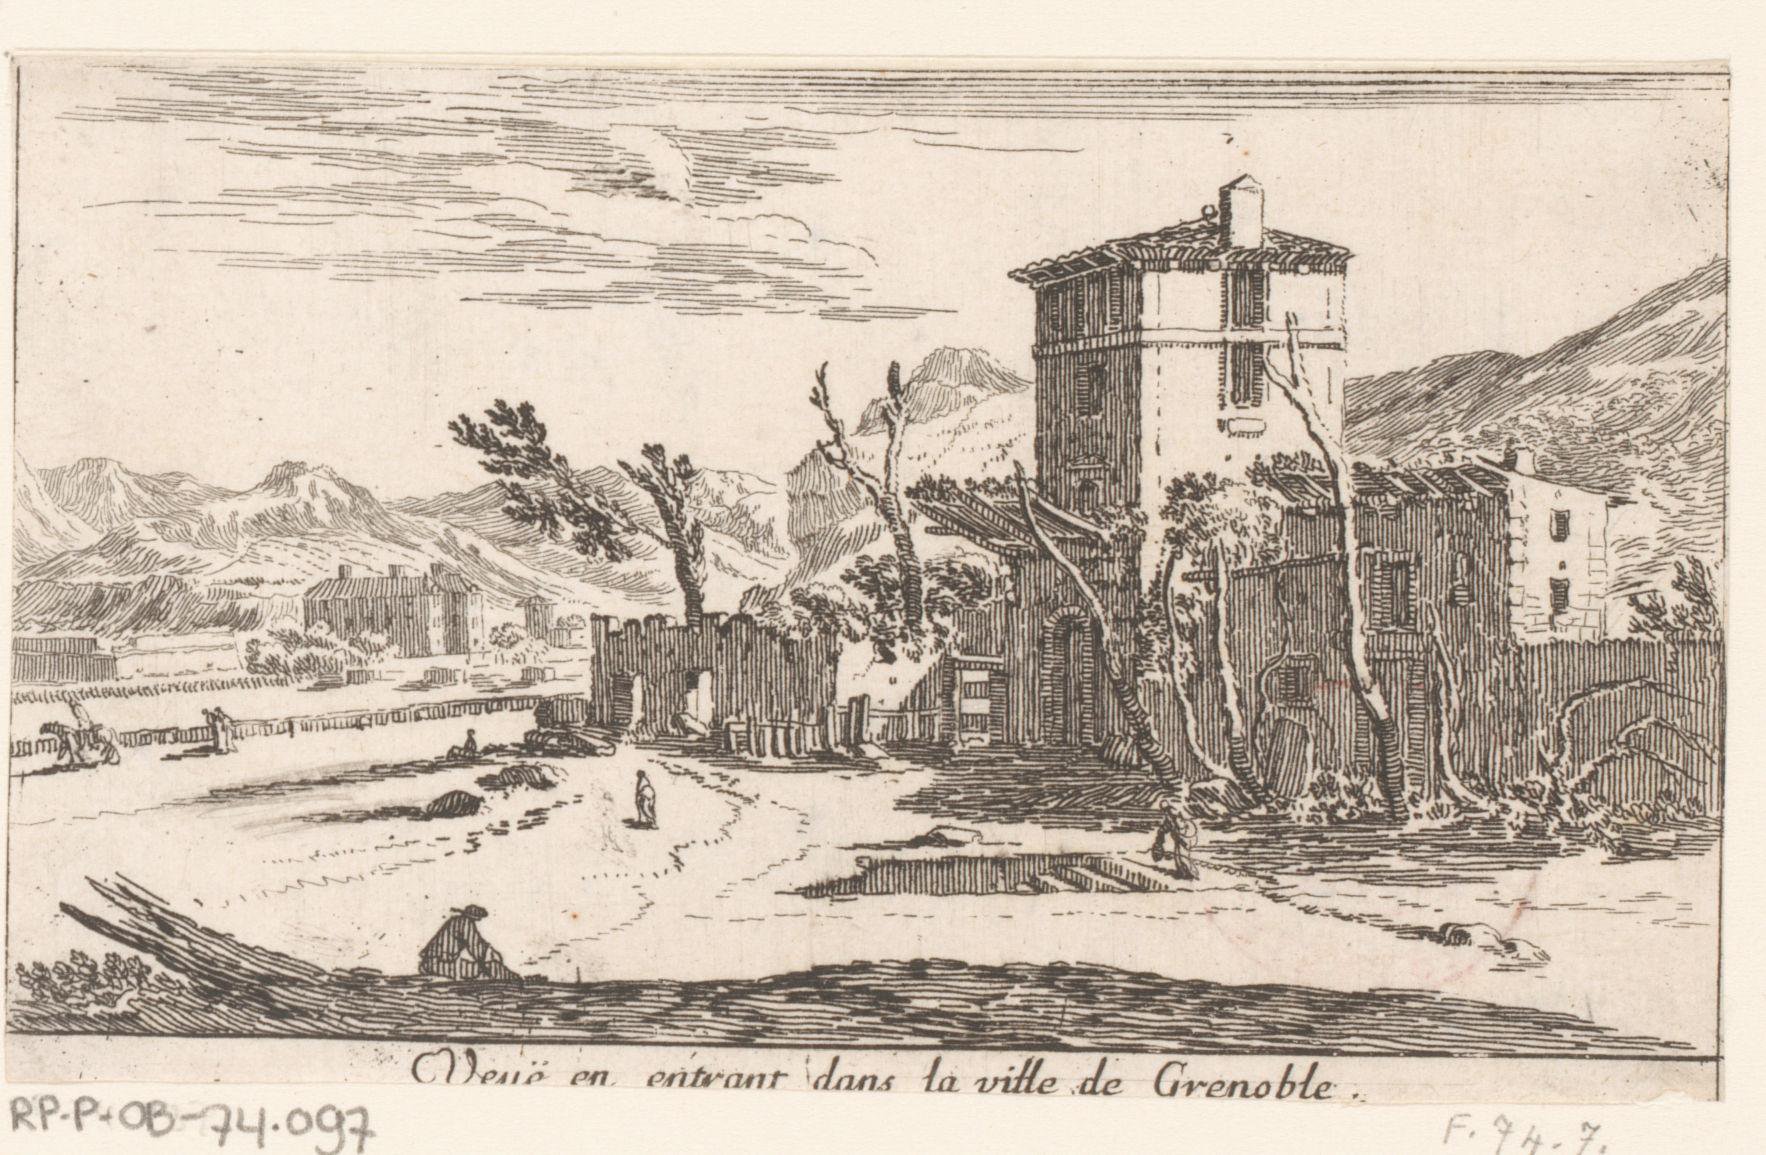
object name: print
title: Gezicht op de toegangspoort van Grenoble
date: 1631-1661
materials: paper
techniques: etching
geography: france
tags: city-gate, city-view, and landscape with man-made constructions (+ city(-scape) with figures, staffage)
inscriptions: collector's mark: Lugt 240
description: Prent maakt deel uit van een ongenummerde serie van zeven prenten.